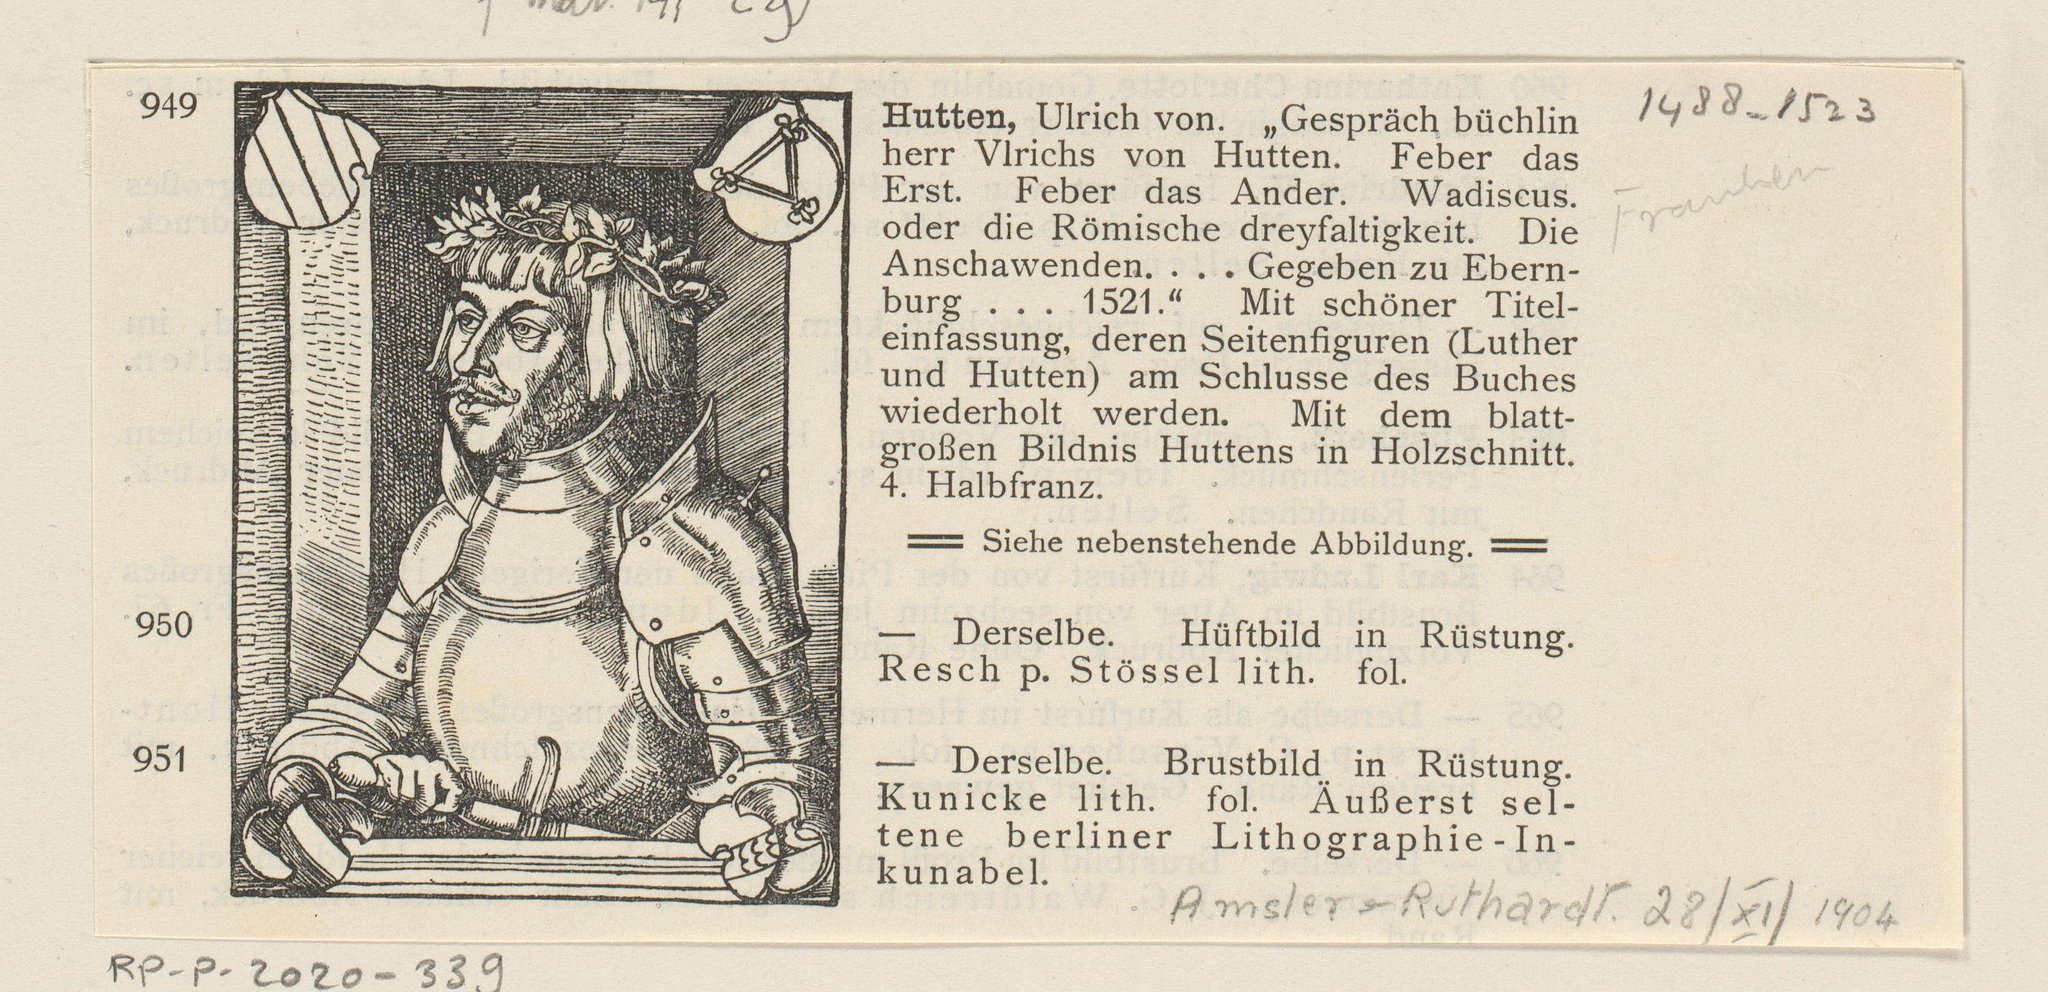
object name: photomechanical print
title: Portret van Ulrich von Hutten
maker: Anonymous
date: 1904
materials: paper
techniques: letterpress printing, printing block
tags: politician, armour, historical persons, writer, poet, author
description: Prent uit: Amsler und Ruthardt. Katalog wertvoller und seltener Historienblätter, Flugblätter, Bildnisse, Städteansichten des XV. bis XIX. Jahrhunderts: (...) Versteigerung 28. November und folgende Tage. Berlijn, s.n., 1904, p. 57.